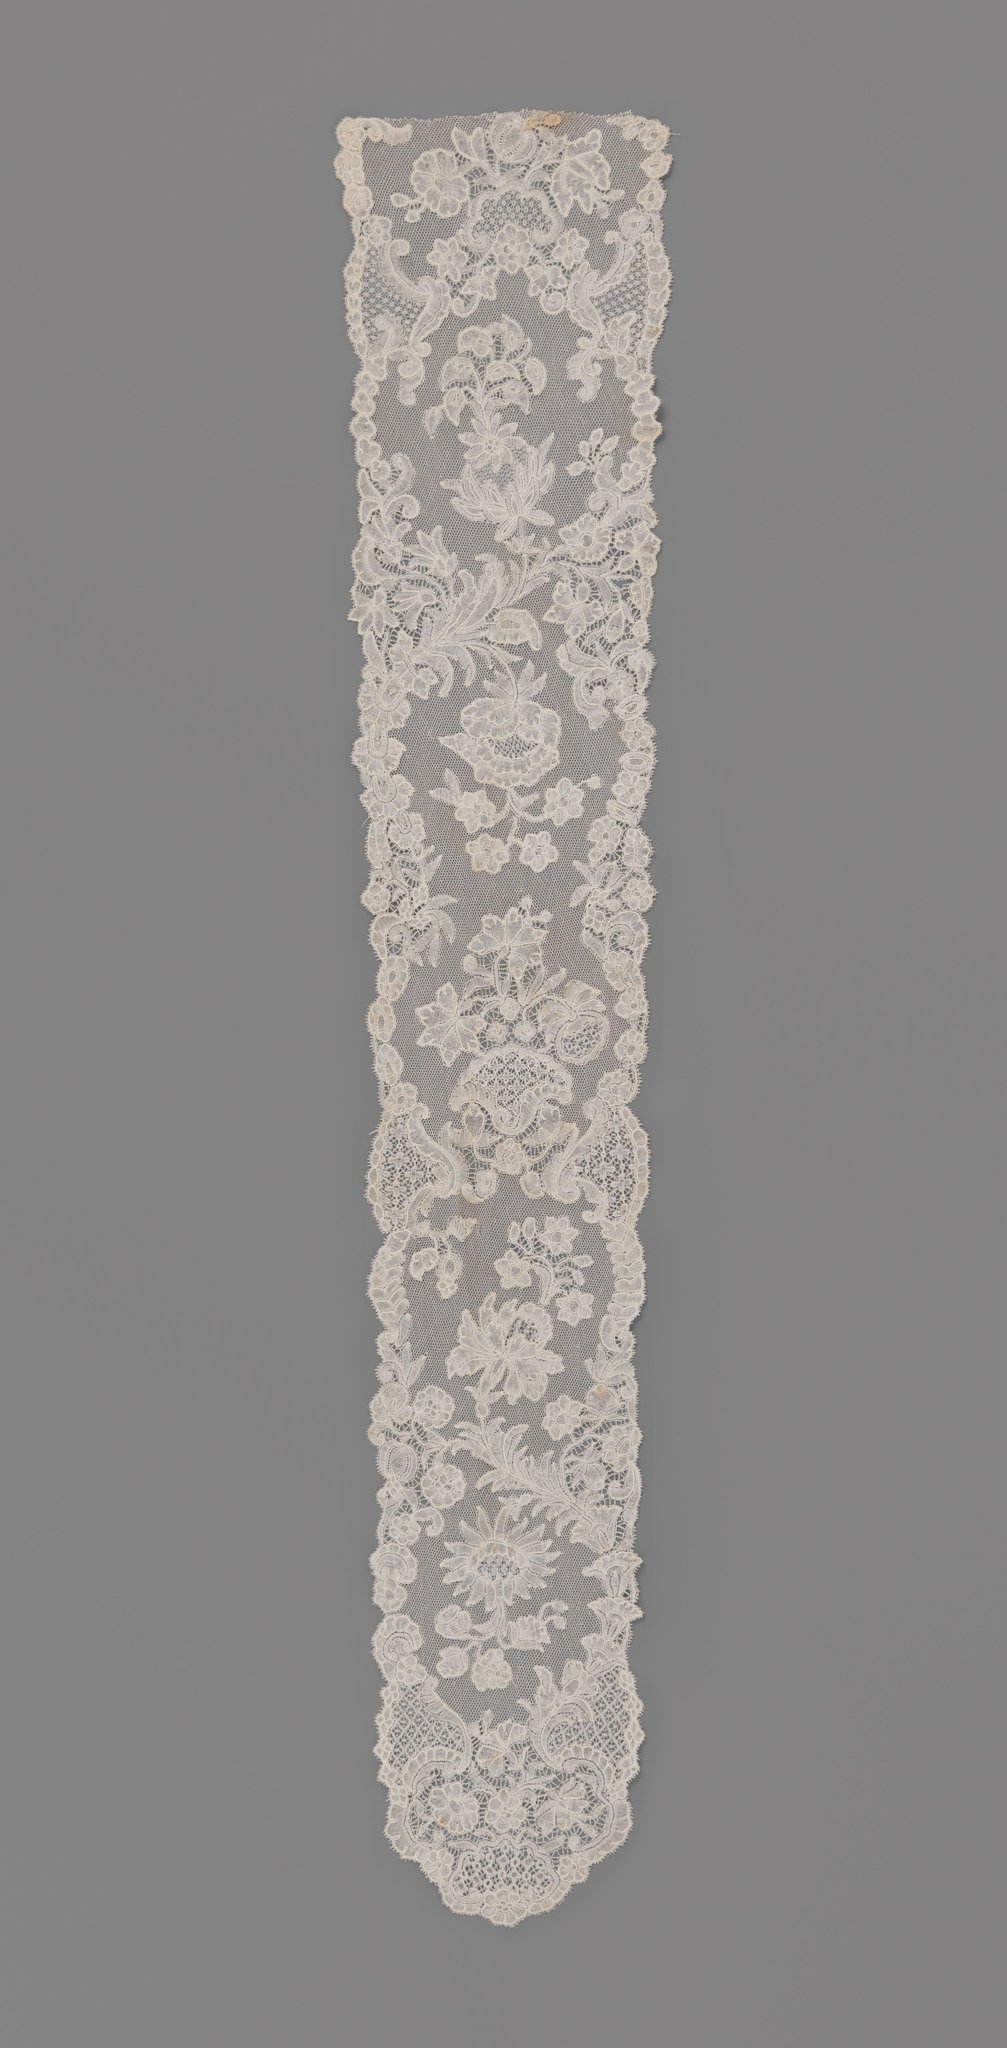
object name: lappet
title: Mutsenslip (barbe) van Brusselse kloskant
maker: Anonymous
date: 1740-1750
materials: linen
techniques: lace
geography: southern netherlands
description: Barbe van kloskant, met geschulpte randen en afgerond uiteinde. De randen hebben bloemen en bladeren met drie keer een paar driehoekige rococo motieven met vulpatronen. Tussen de bovenste twee motieven komen drie grote bloemen uit schelp- of waaierachtige motieven. Het uiteinde heeft een dergelijk motief met daarboven een bloemtak. De twee tussenvelden zijn gevuld met overdwars geplaatse tak met twee grote bloemen.